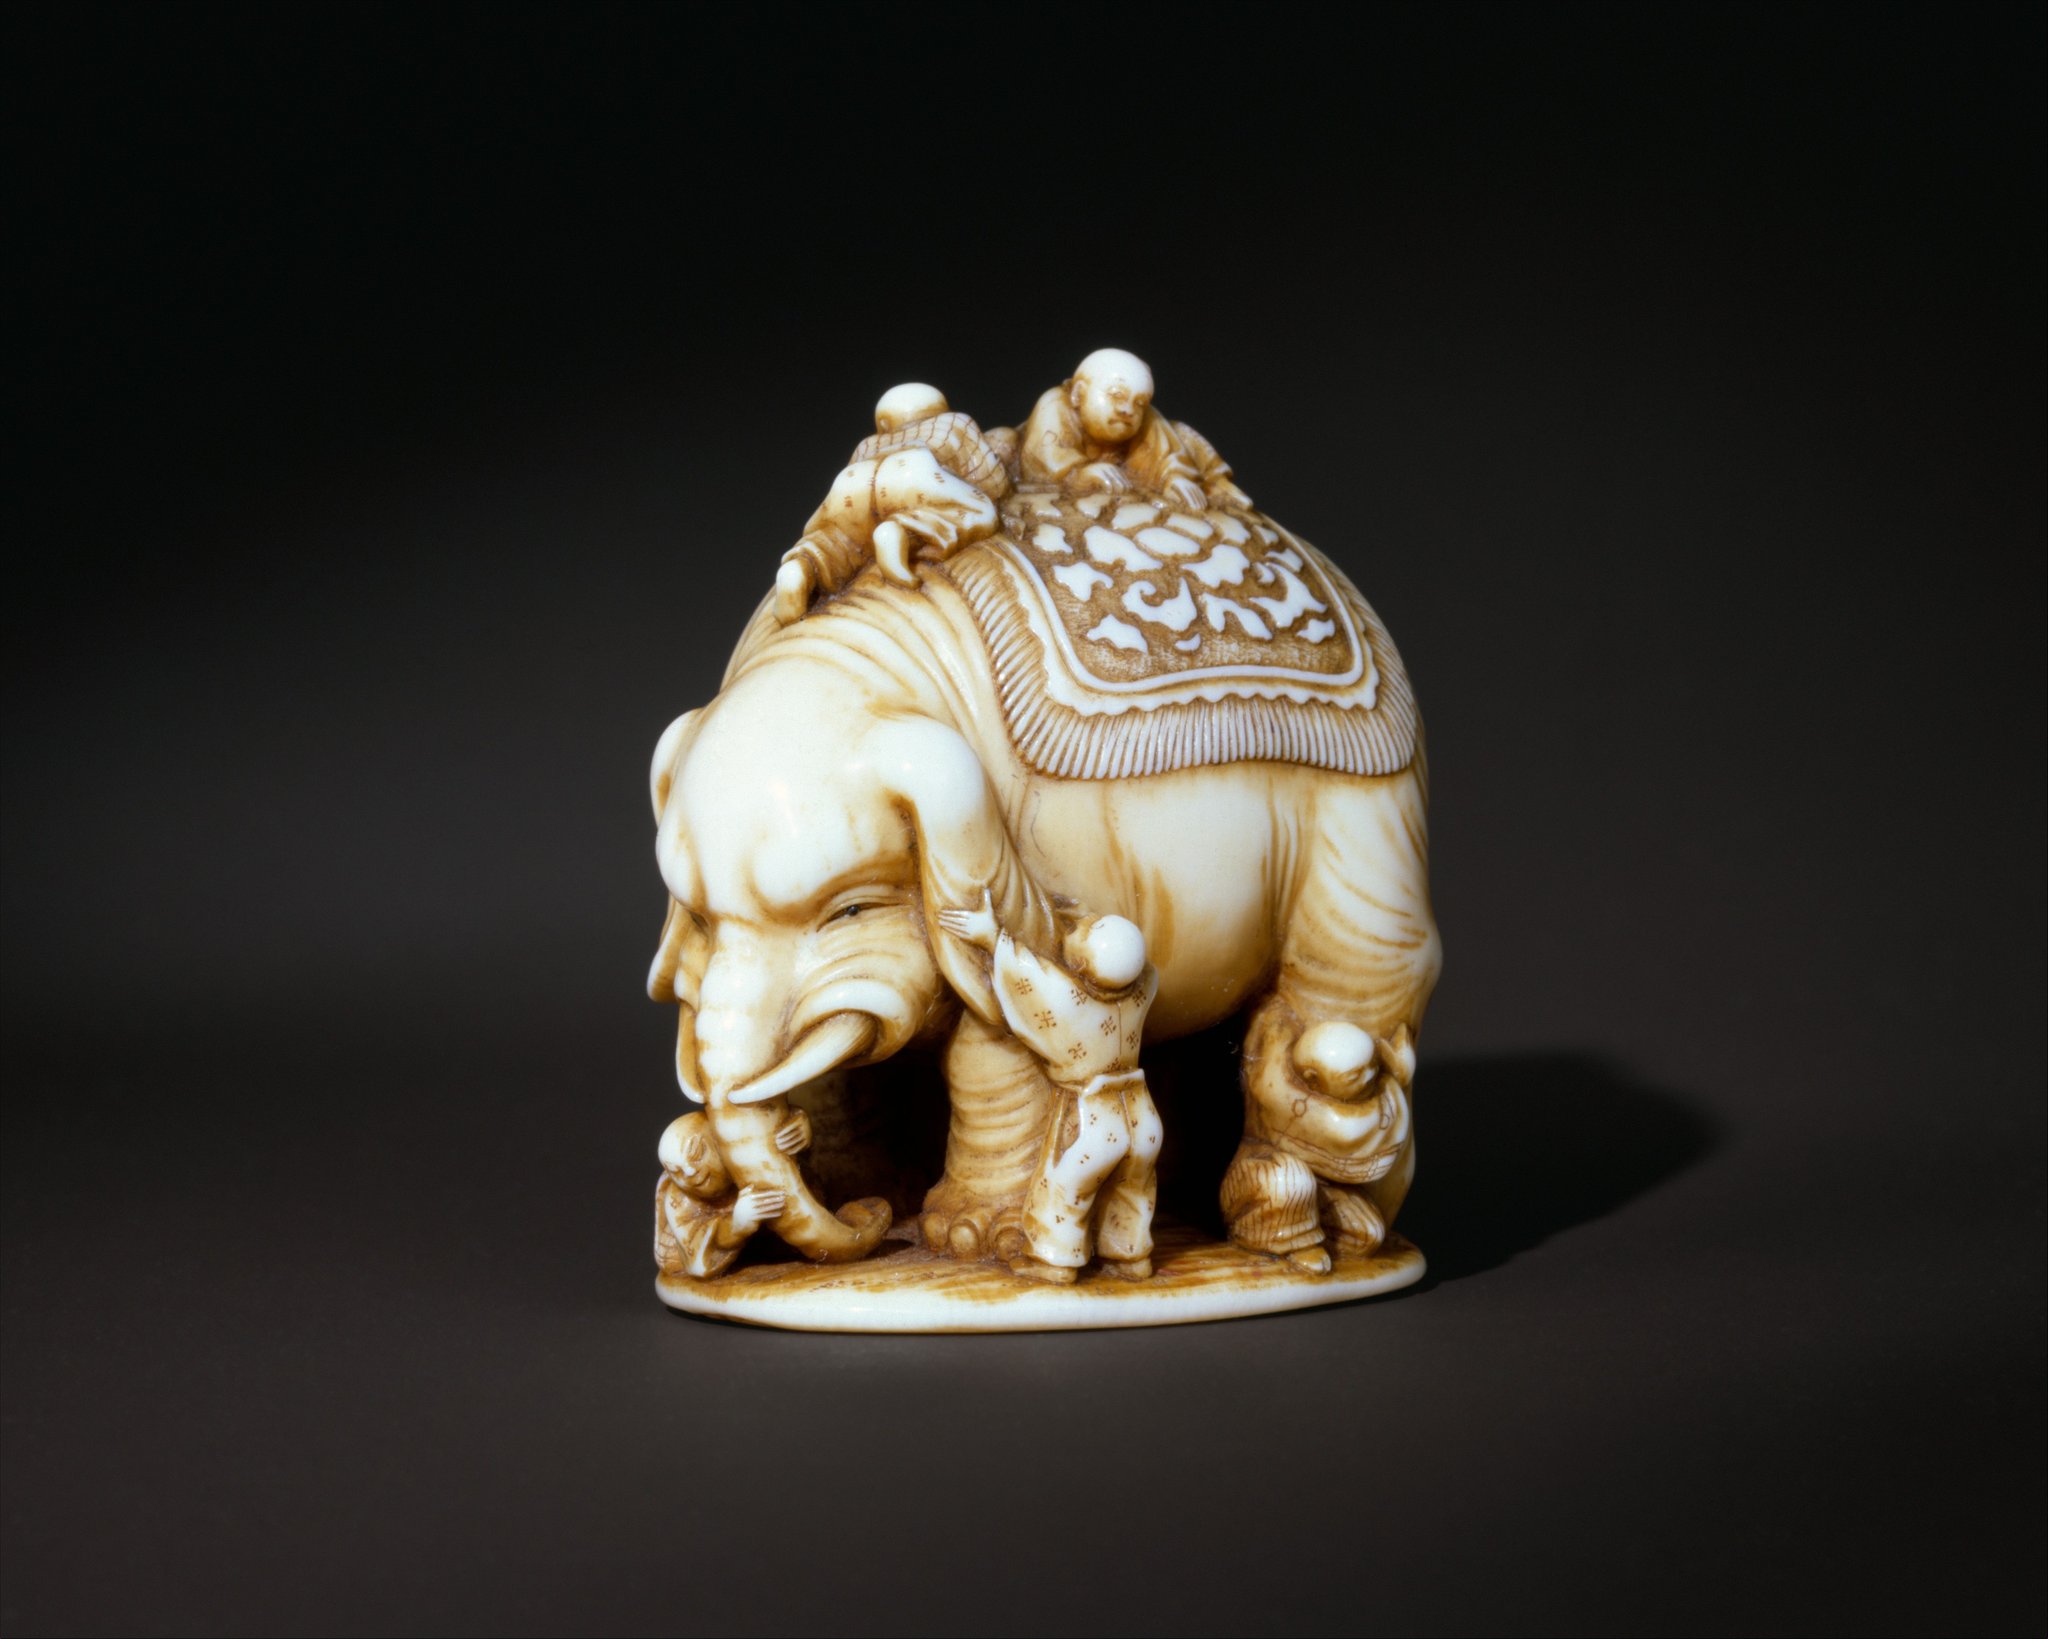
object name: netsuke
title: Blind Men and the Elephant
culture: japanese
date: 1801-1900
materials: ivory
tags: elephants